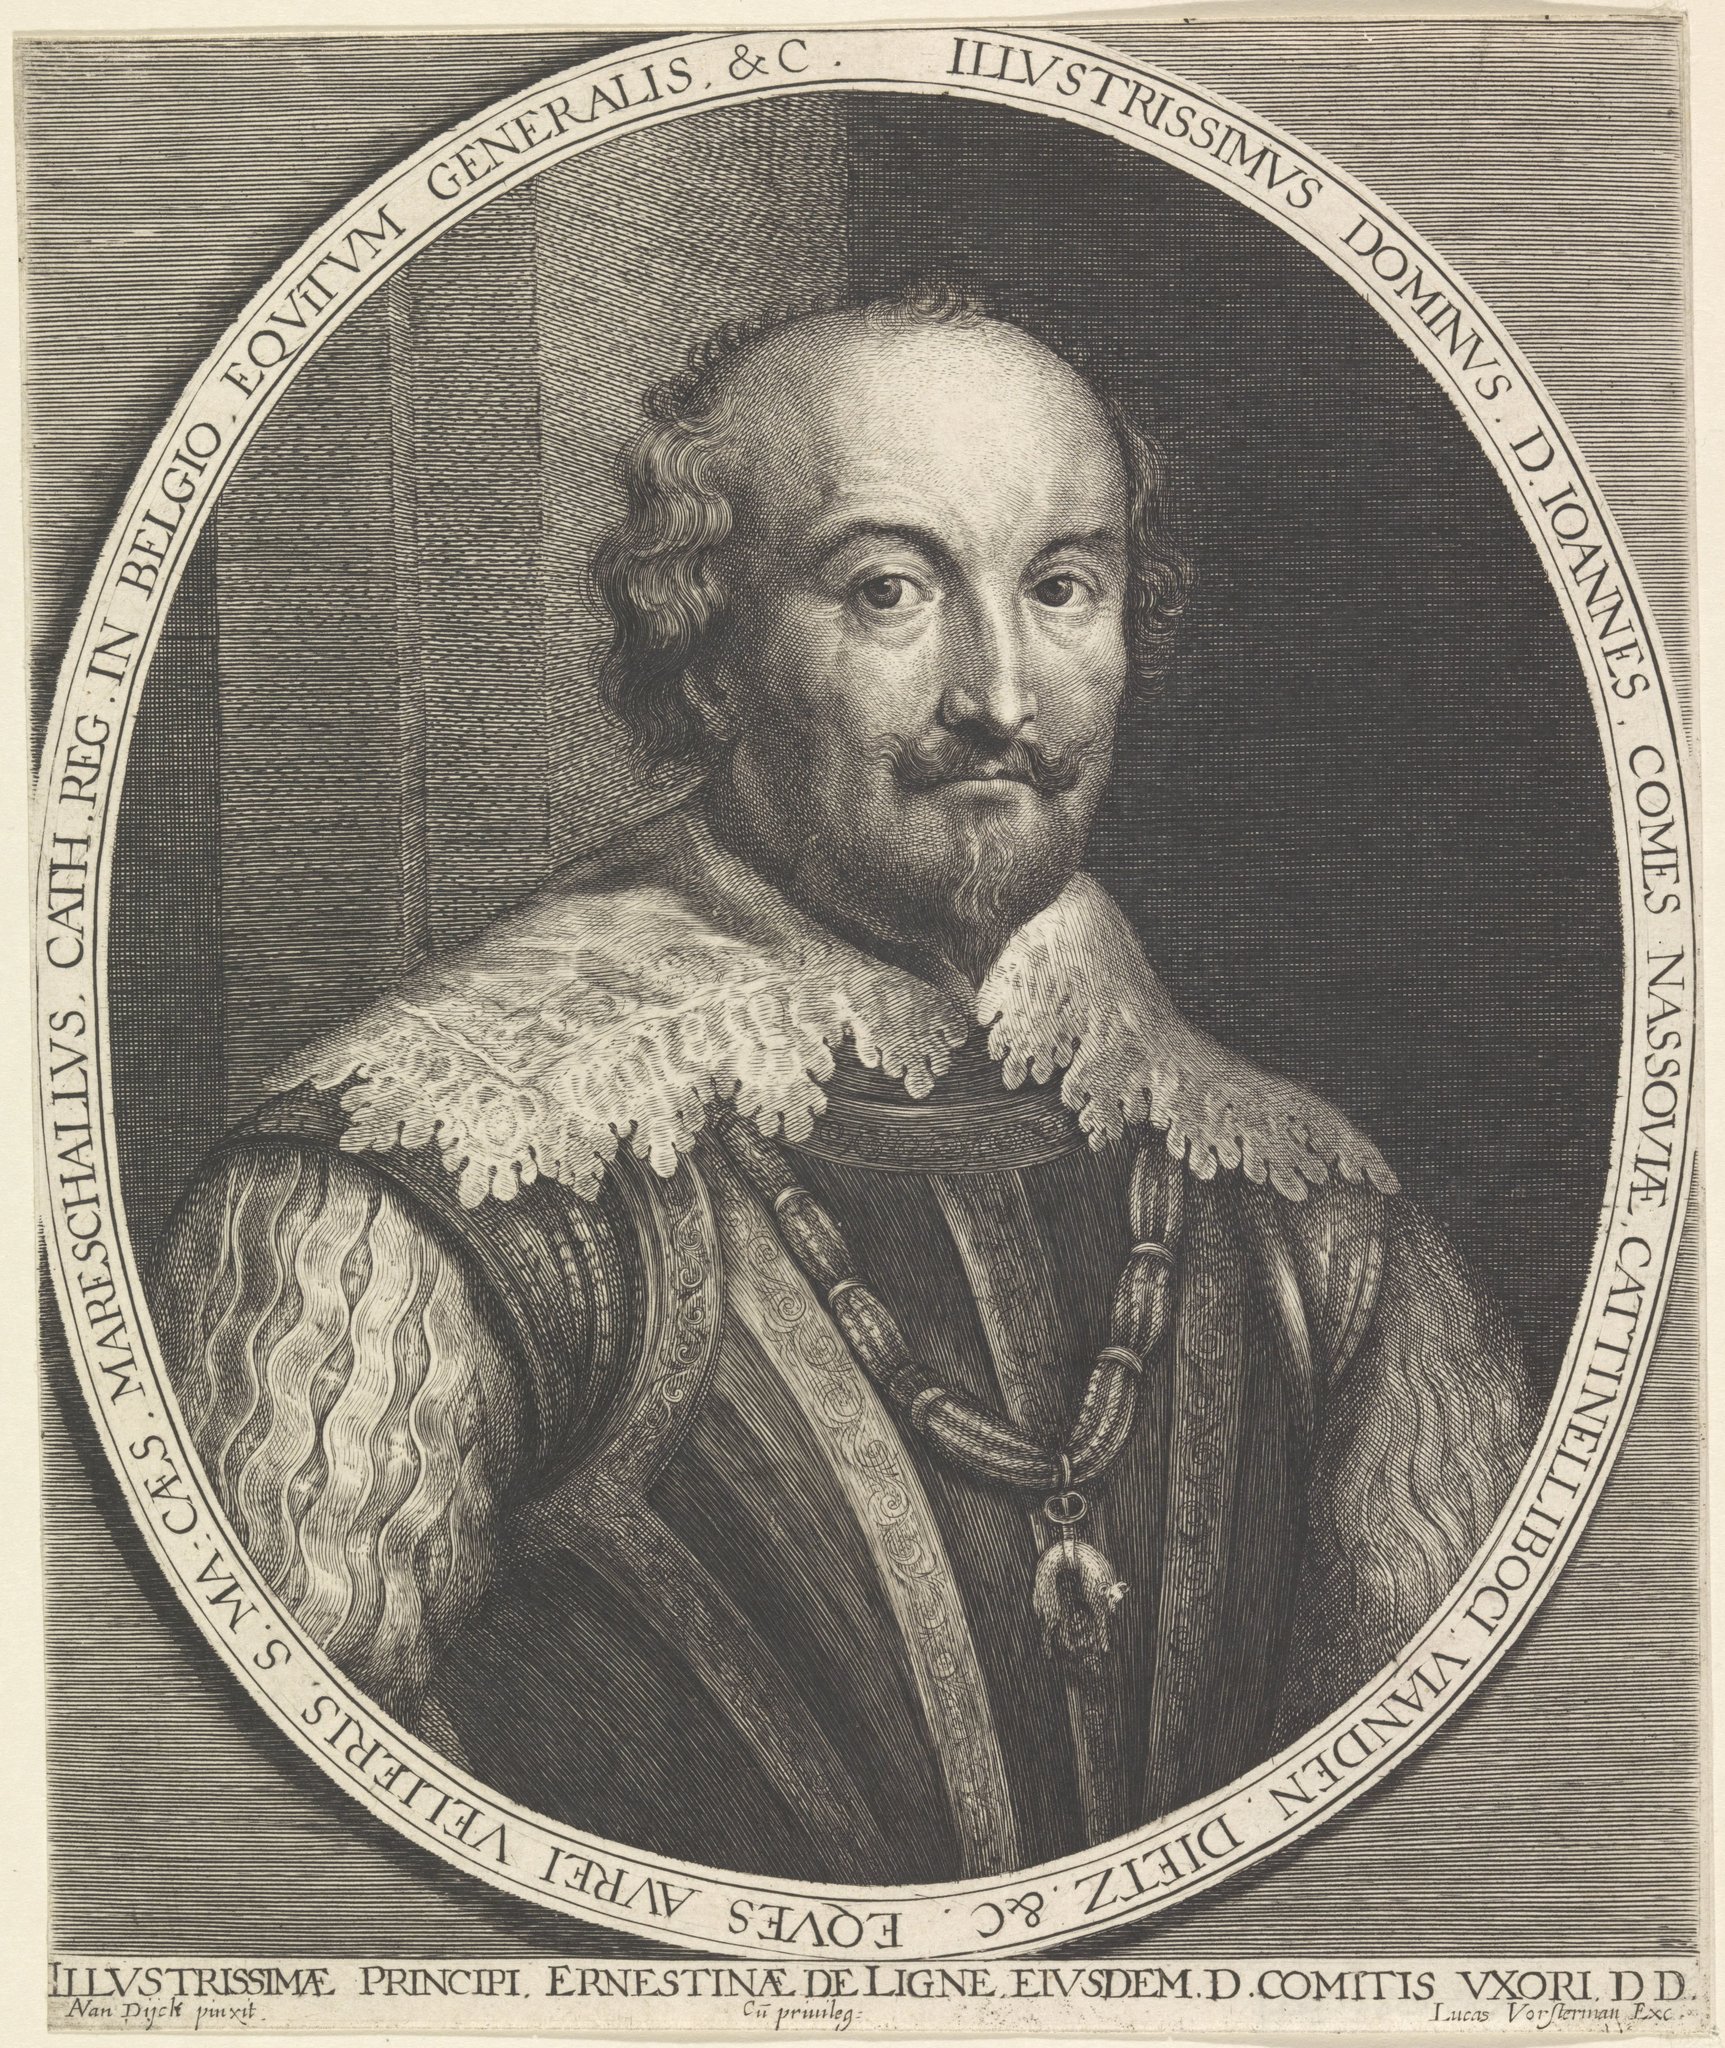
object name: print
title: Portret van Johan VIII, graaf van Nassau-Siegen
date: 1605-1675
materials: paper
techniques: engraving, etching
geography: antwerp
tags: knighthood order of the golden fleece - insignia of a knighthood order, e.g.: badge, chain (with name of order)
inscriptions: collector's mark: Lugt 240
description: De hier vermelde titel verwijst naar de hoogst verkregen titel van de geportretteerde, niet per se naar de titel die de geportretteerde op deze voorstelling draagt.